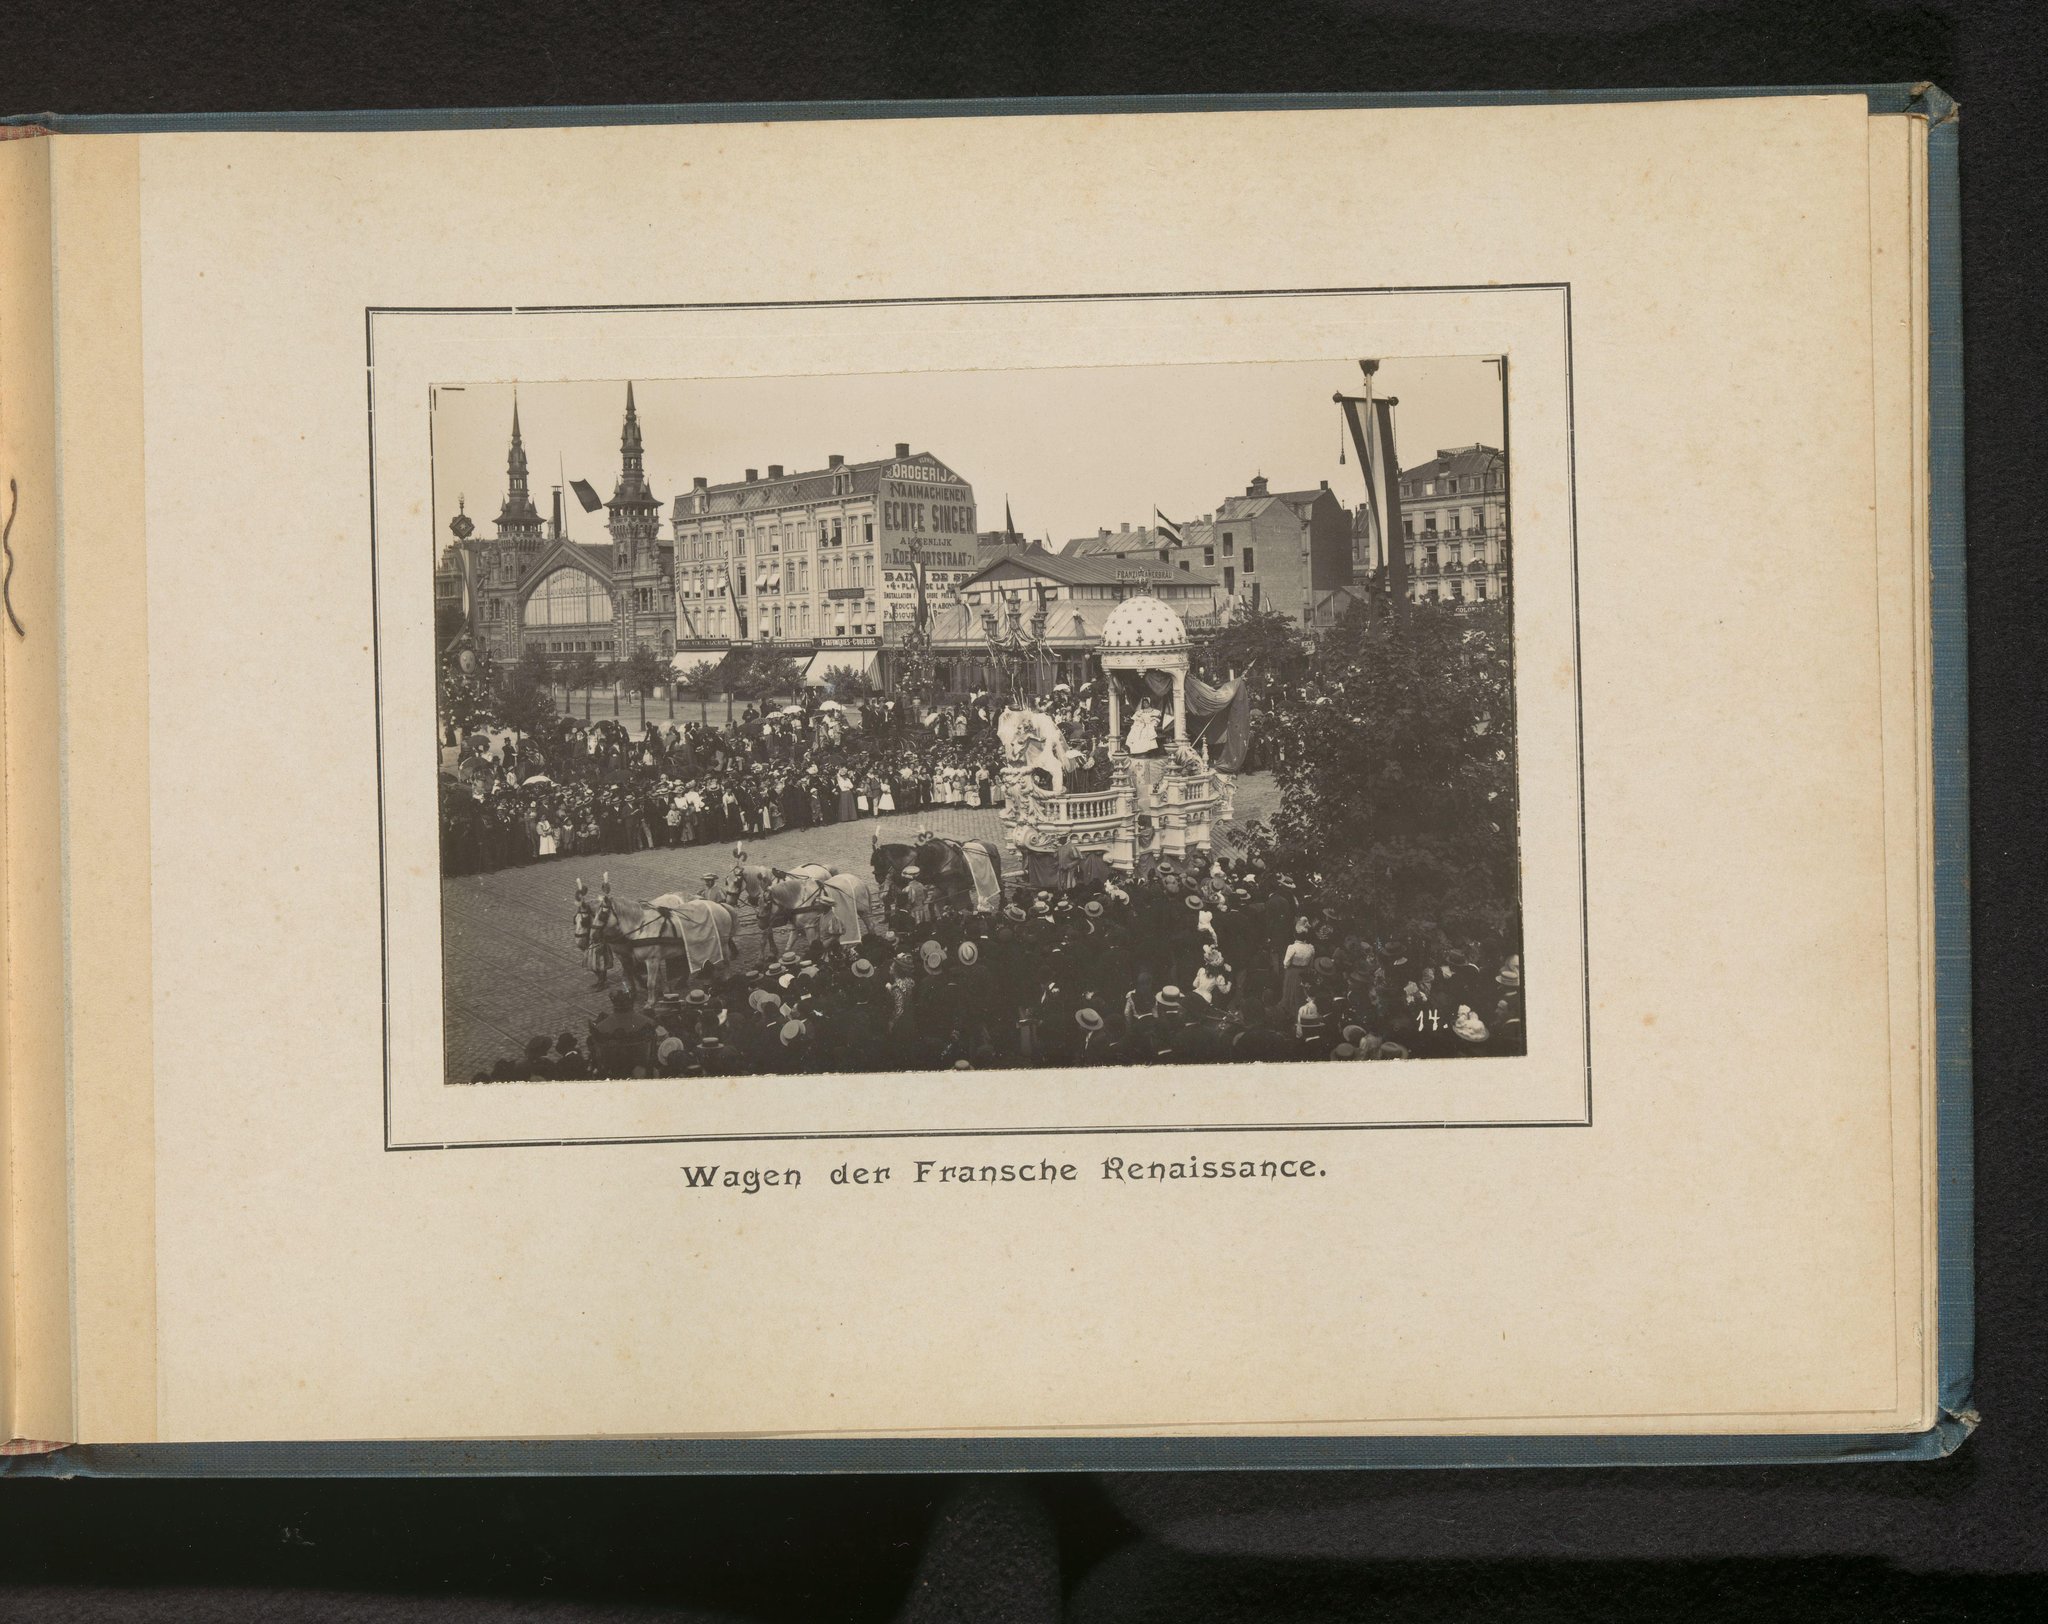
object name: photograph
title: Wagen der Fransche Renaissance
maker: Anonymous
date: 1899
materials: photographic support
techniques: printing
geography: antwerp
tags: animal traction, animal-drawn vehicle (carriage etc.), festivities (+ decorated float, wagon ~ festive activities), civic architecture; edifices; dwellings, antwerp